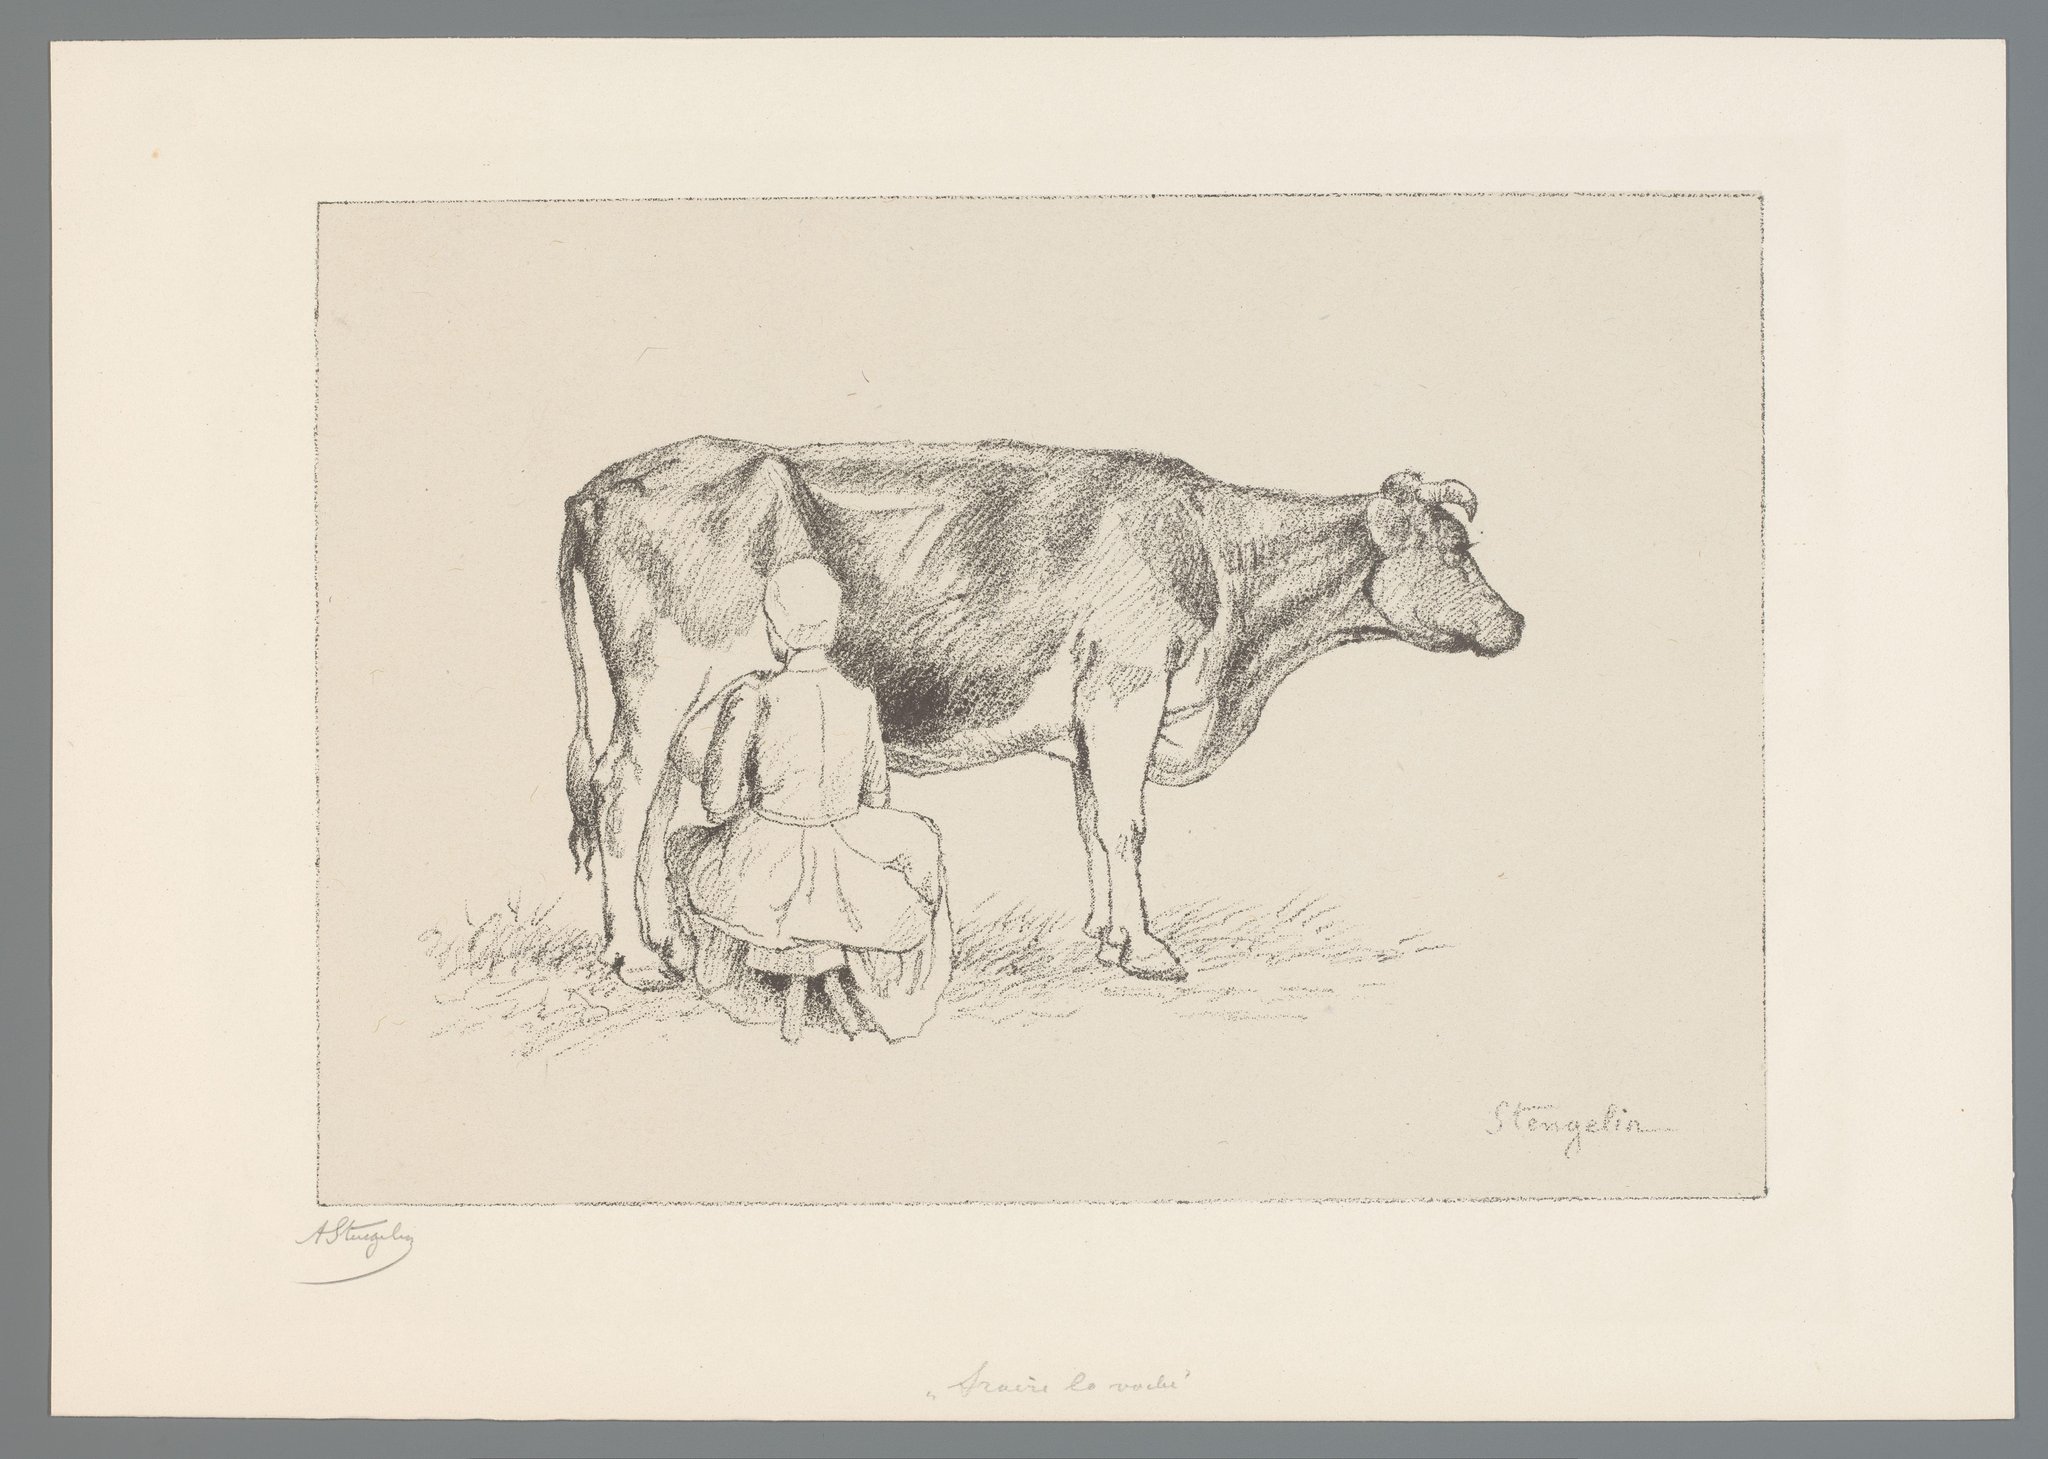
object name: print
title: Vrouw melkt koe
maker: alphonse stengelin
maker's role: painter, print maker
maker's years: 1852-1938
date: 1876-1910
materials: paper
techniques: lithograph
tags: cow, adult woman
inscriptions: collector's mark: Lugt 2228